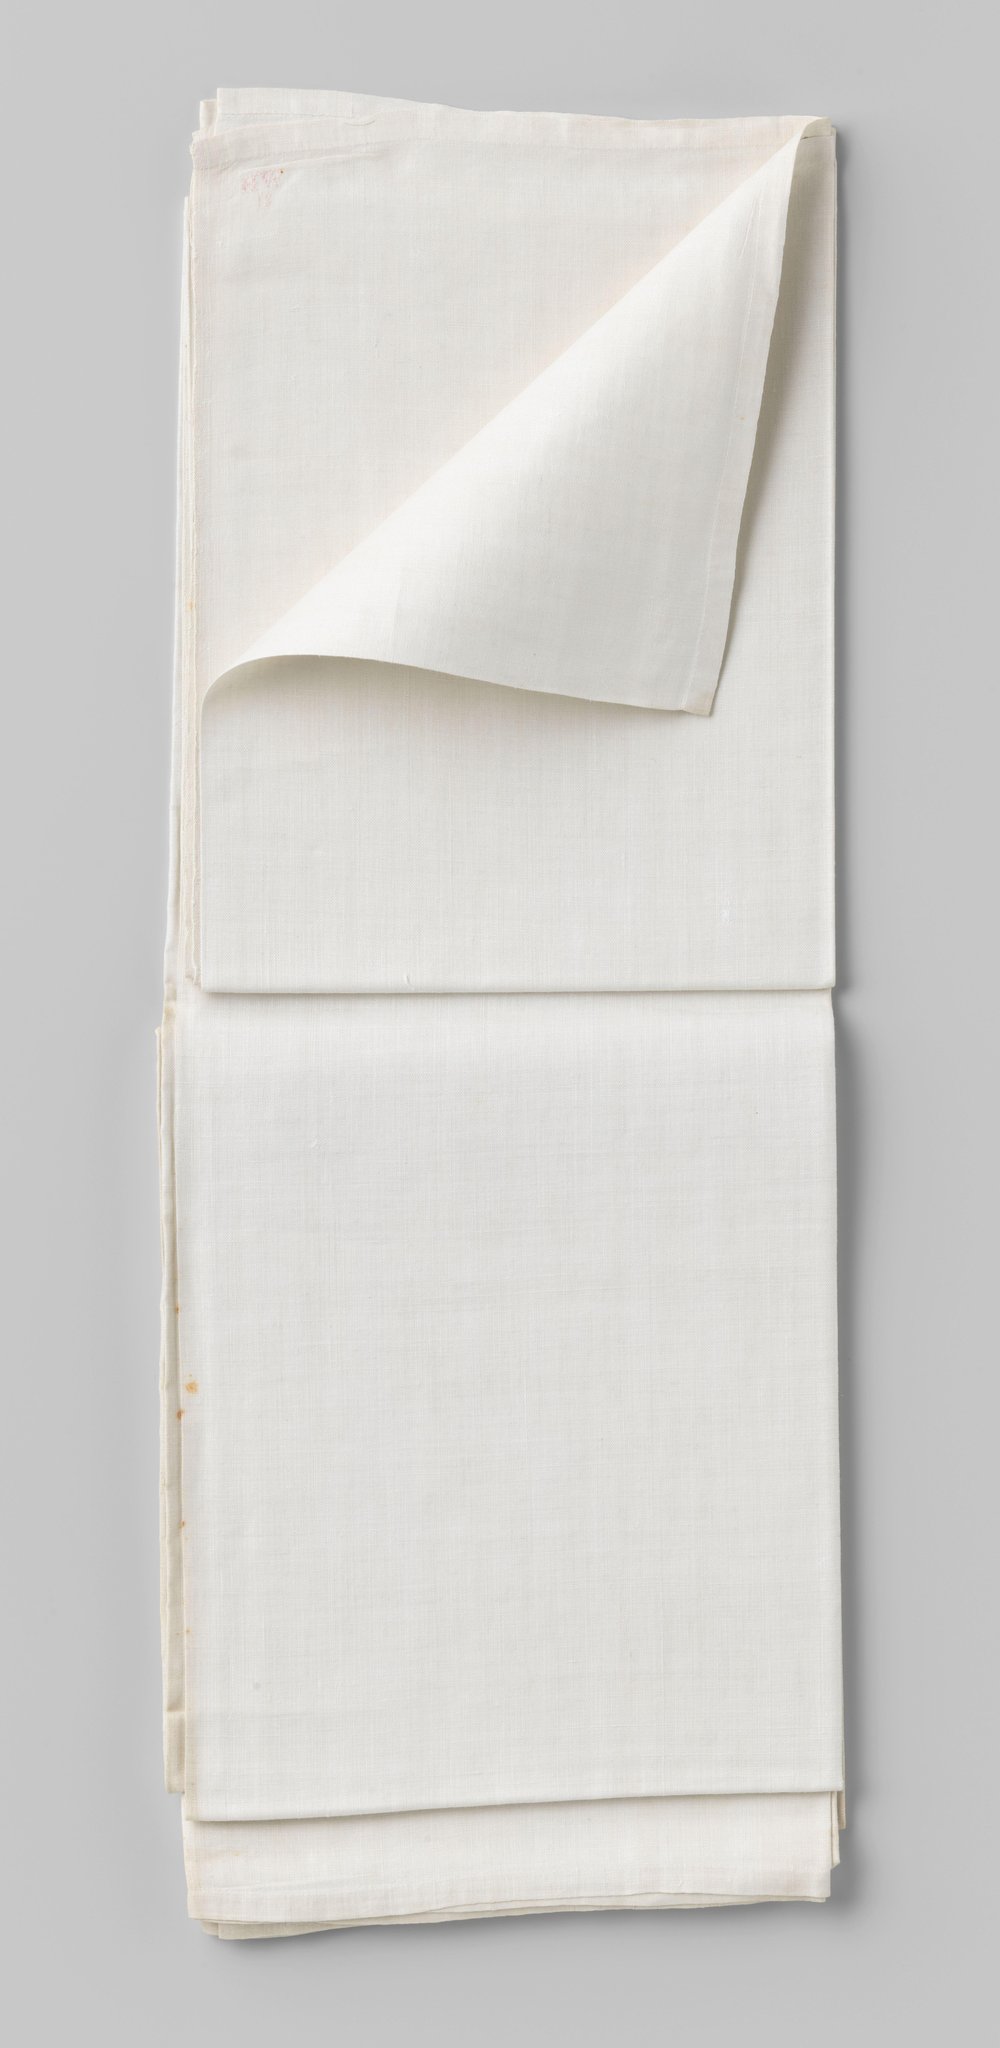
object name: kinderlaken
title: Kinderlaken, merk HW 18.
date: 1852-1860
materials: linen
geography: northern netherlands